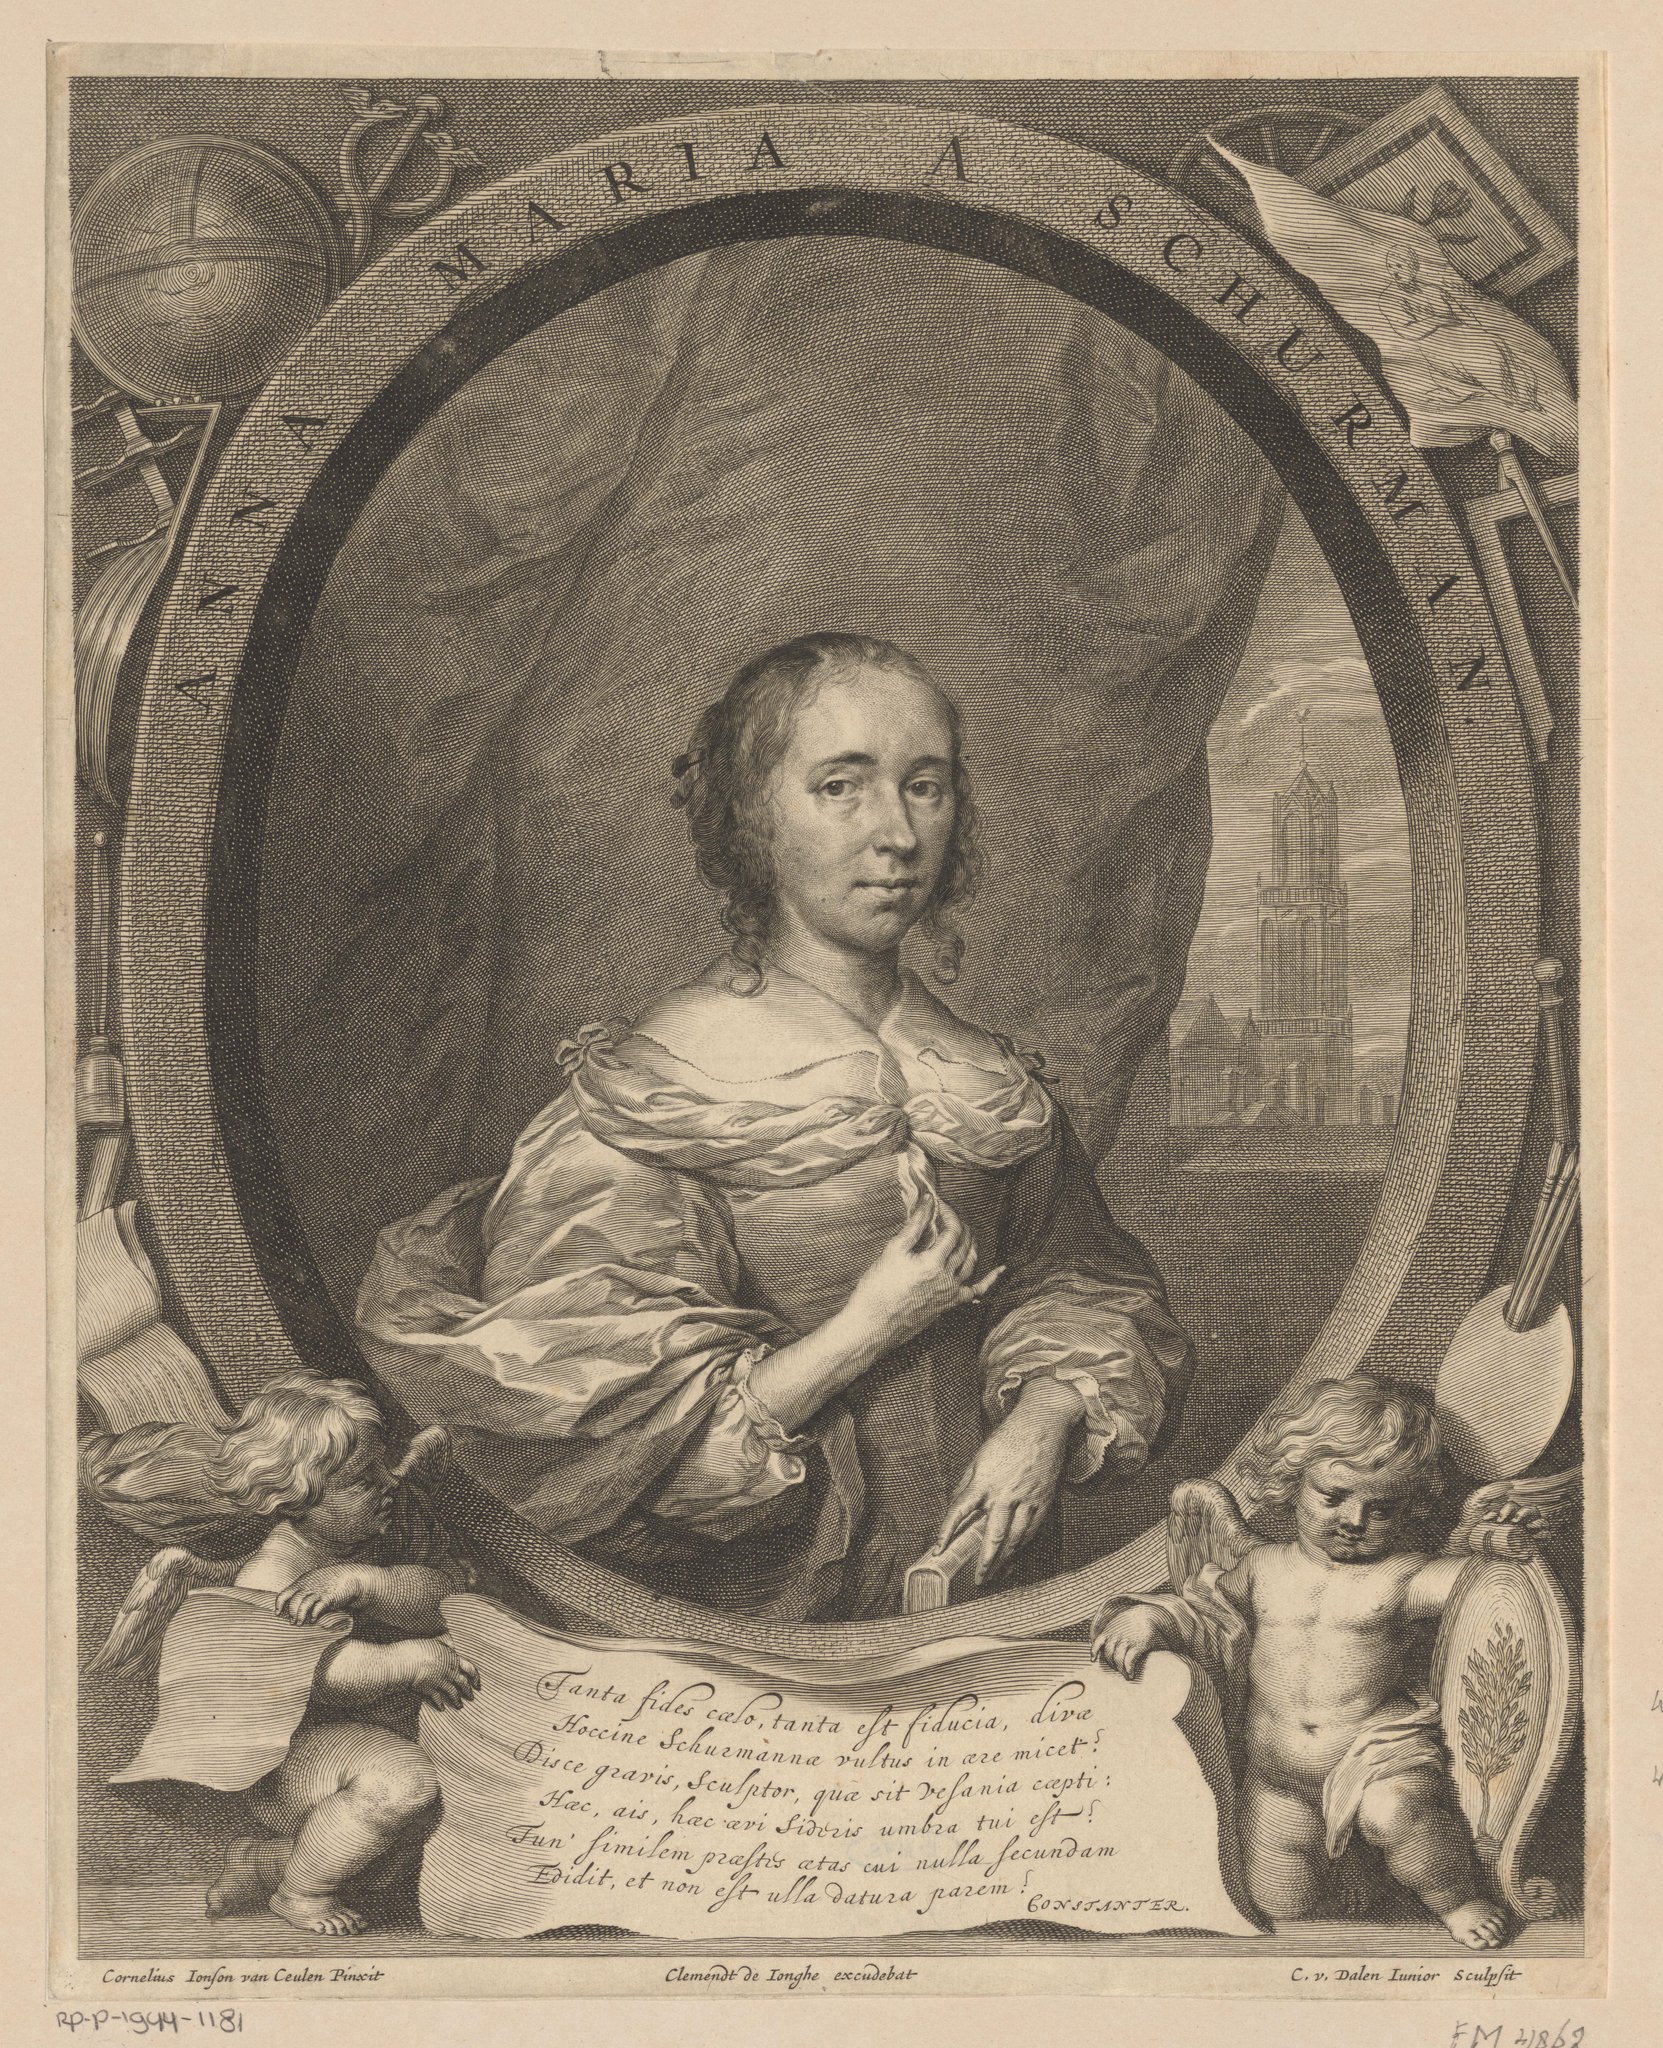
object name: print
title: Portret van Anna Maria van Schurman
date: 1657-1664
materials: paper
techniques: engraving, etching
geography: amsterdam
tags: print maker, anna maria van schurman, historical persons - bb - woman, portrait, self-portrait of artist, writer, poet, author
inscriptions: collector's mark: Lugt 2228, collector's mark: Lugt 963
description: Hollstein beschrijft slechts drie staten, in de collectie van het RMA bevinden zich drie verschillende staten voor de letter, bij Hollstein vermeld als de eerste staat. Daarmee komt het totaal op vijf staten.